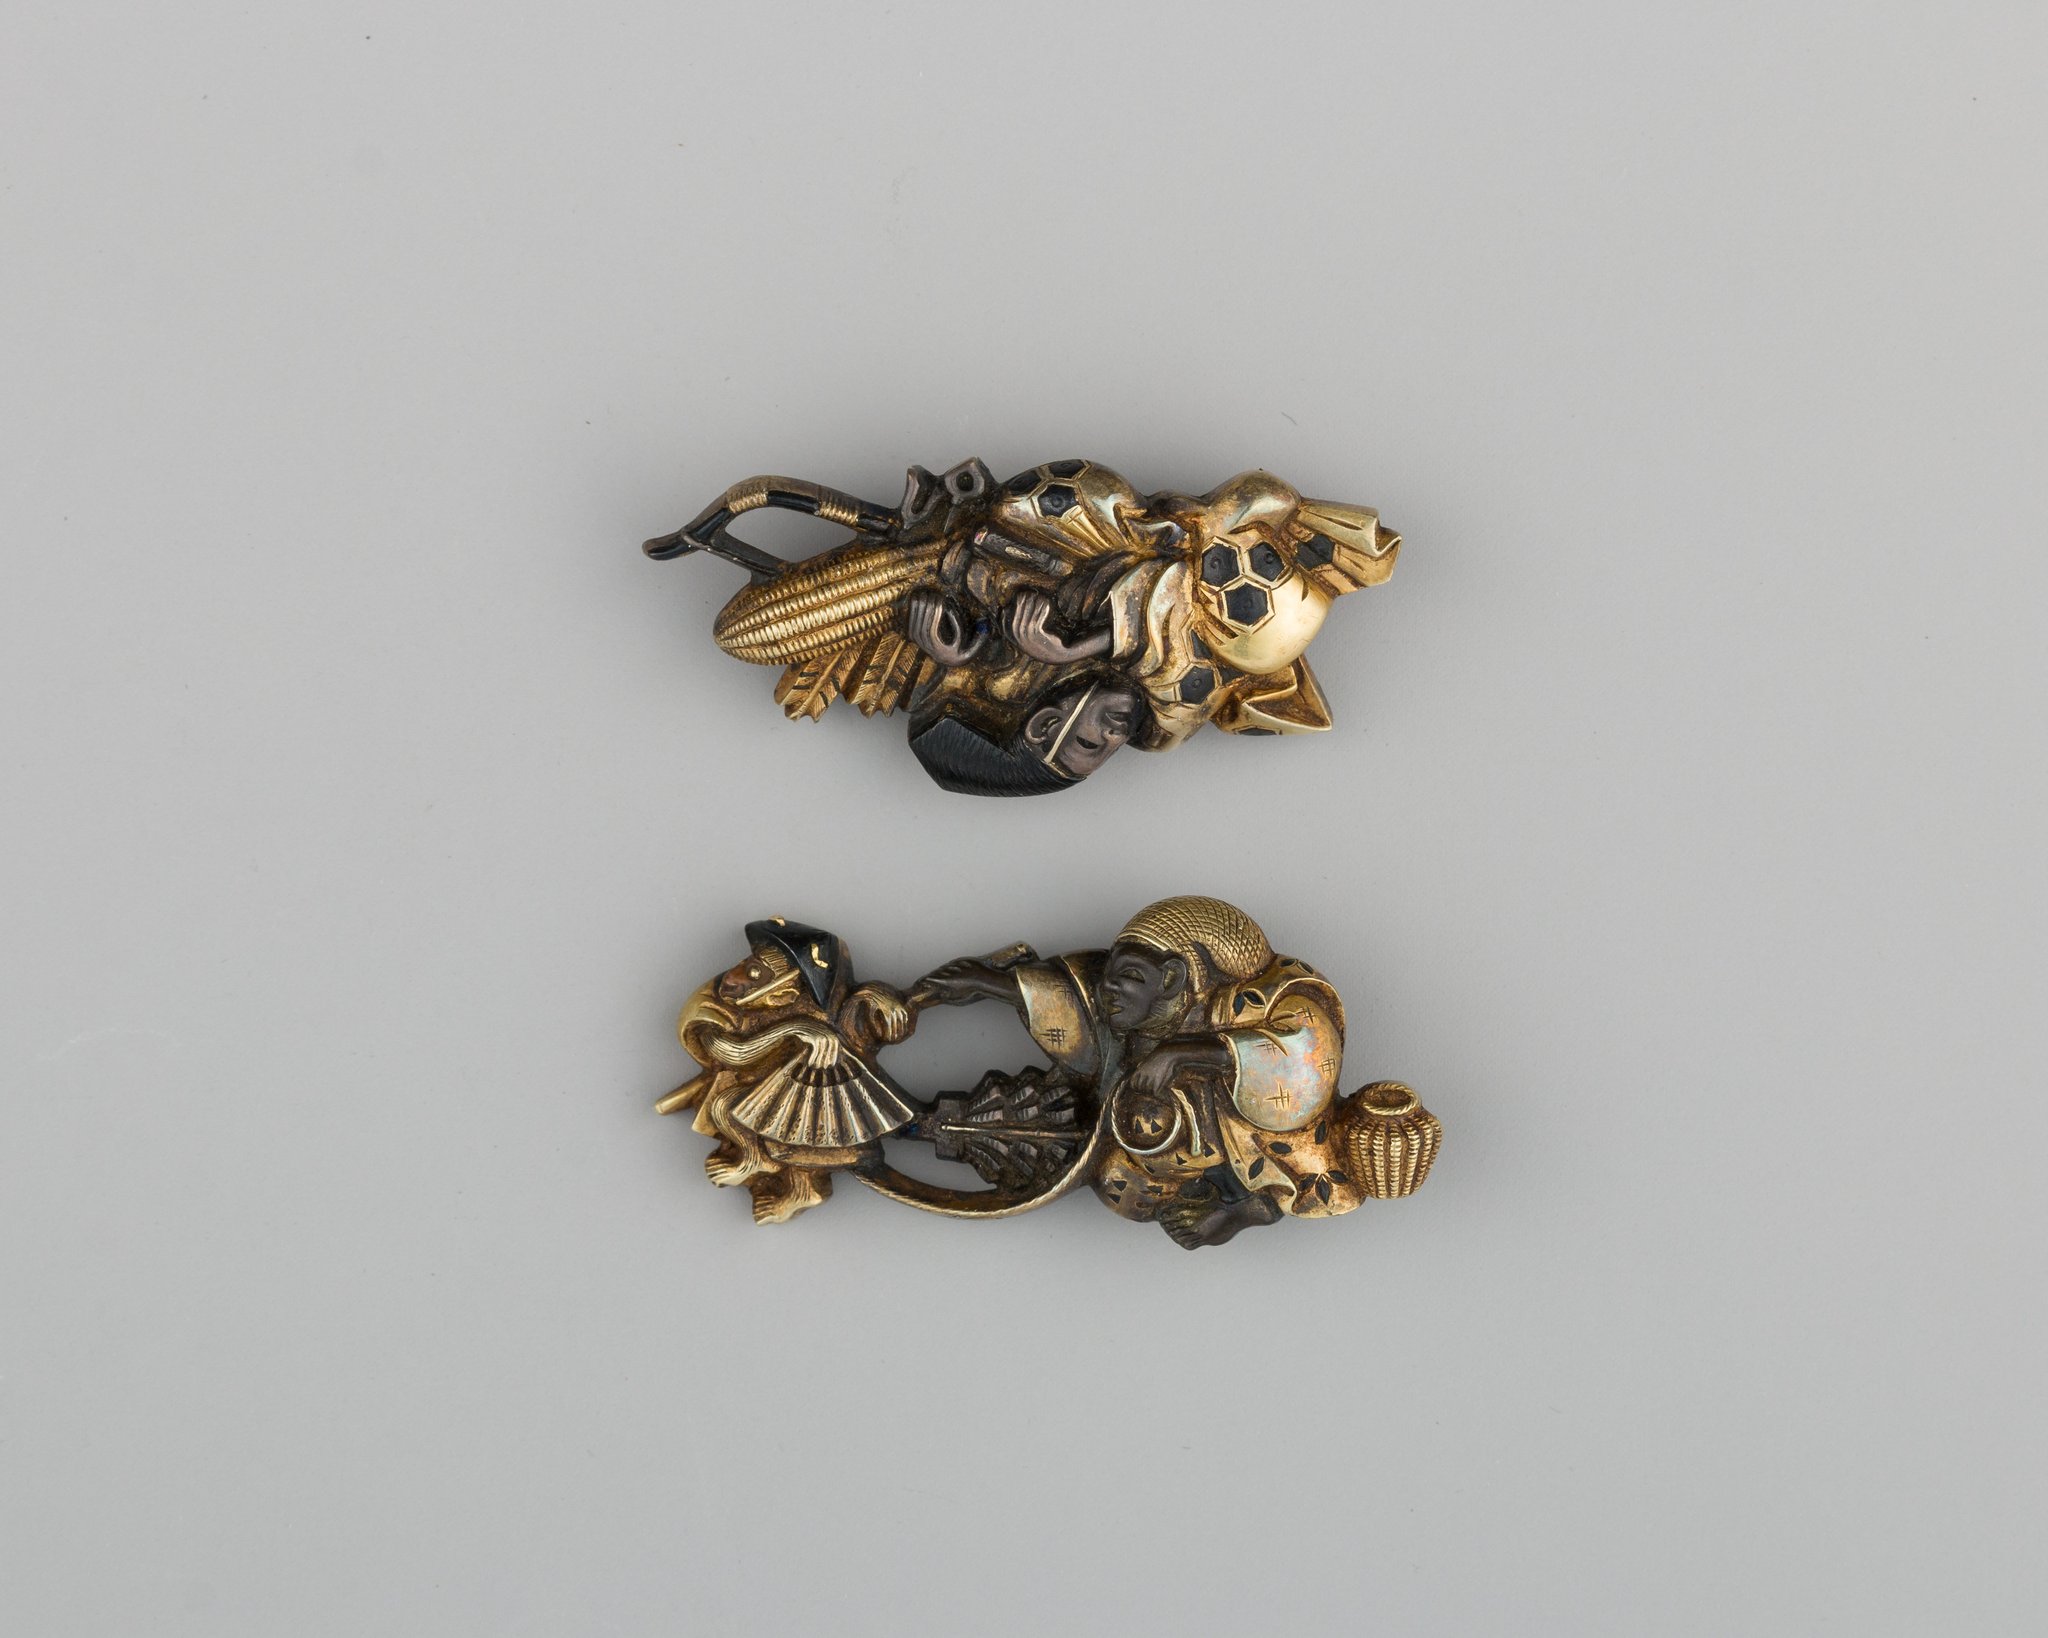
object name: pair of sword grip ornament menuki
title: Pair of Sword-Grip Ornaments (Menuki)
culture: japanese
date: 1701-1800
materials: gold alloy, silver alloy, gold, silver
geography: japan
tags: human figures,insects